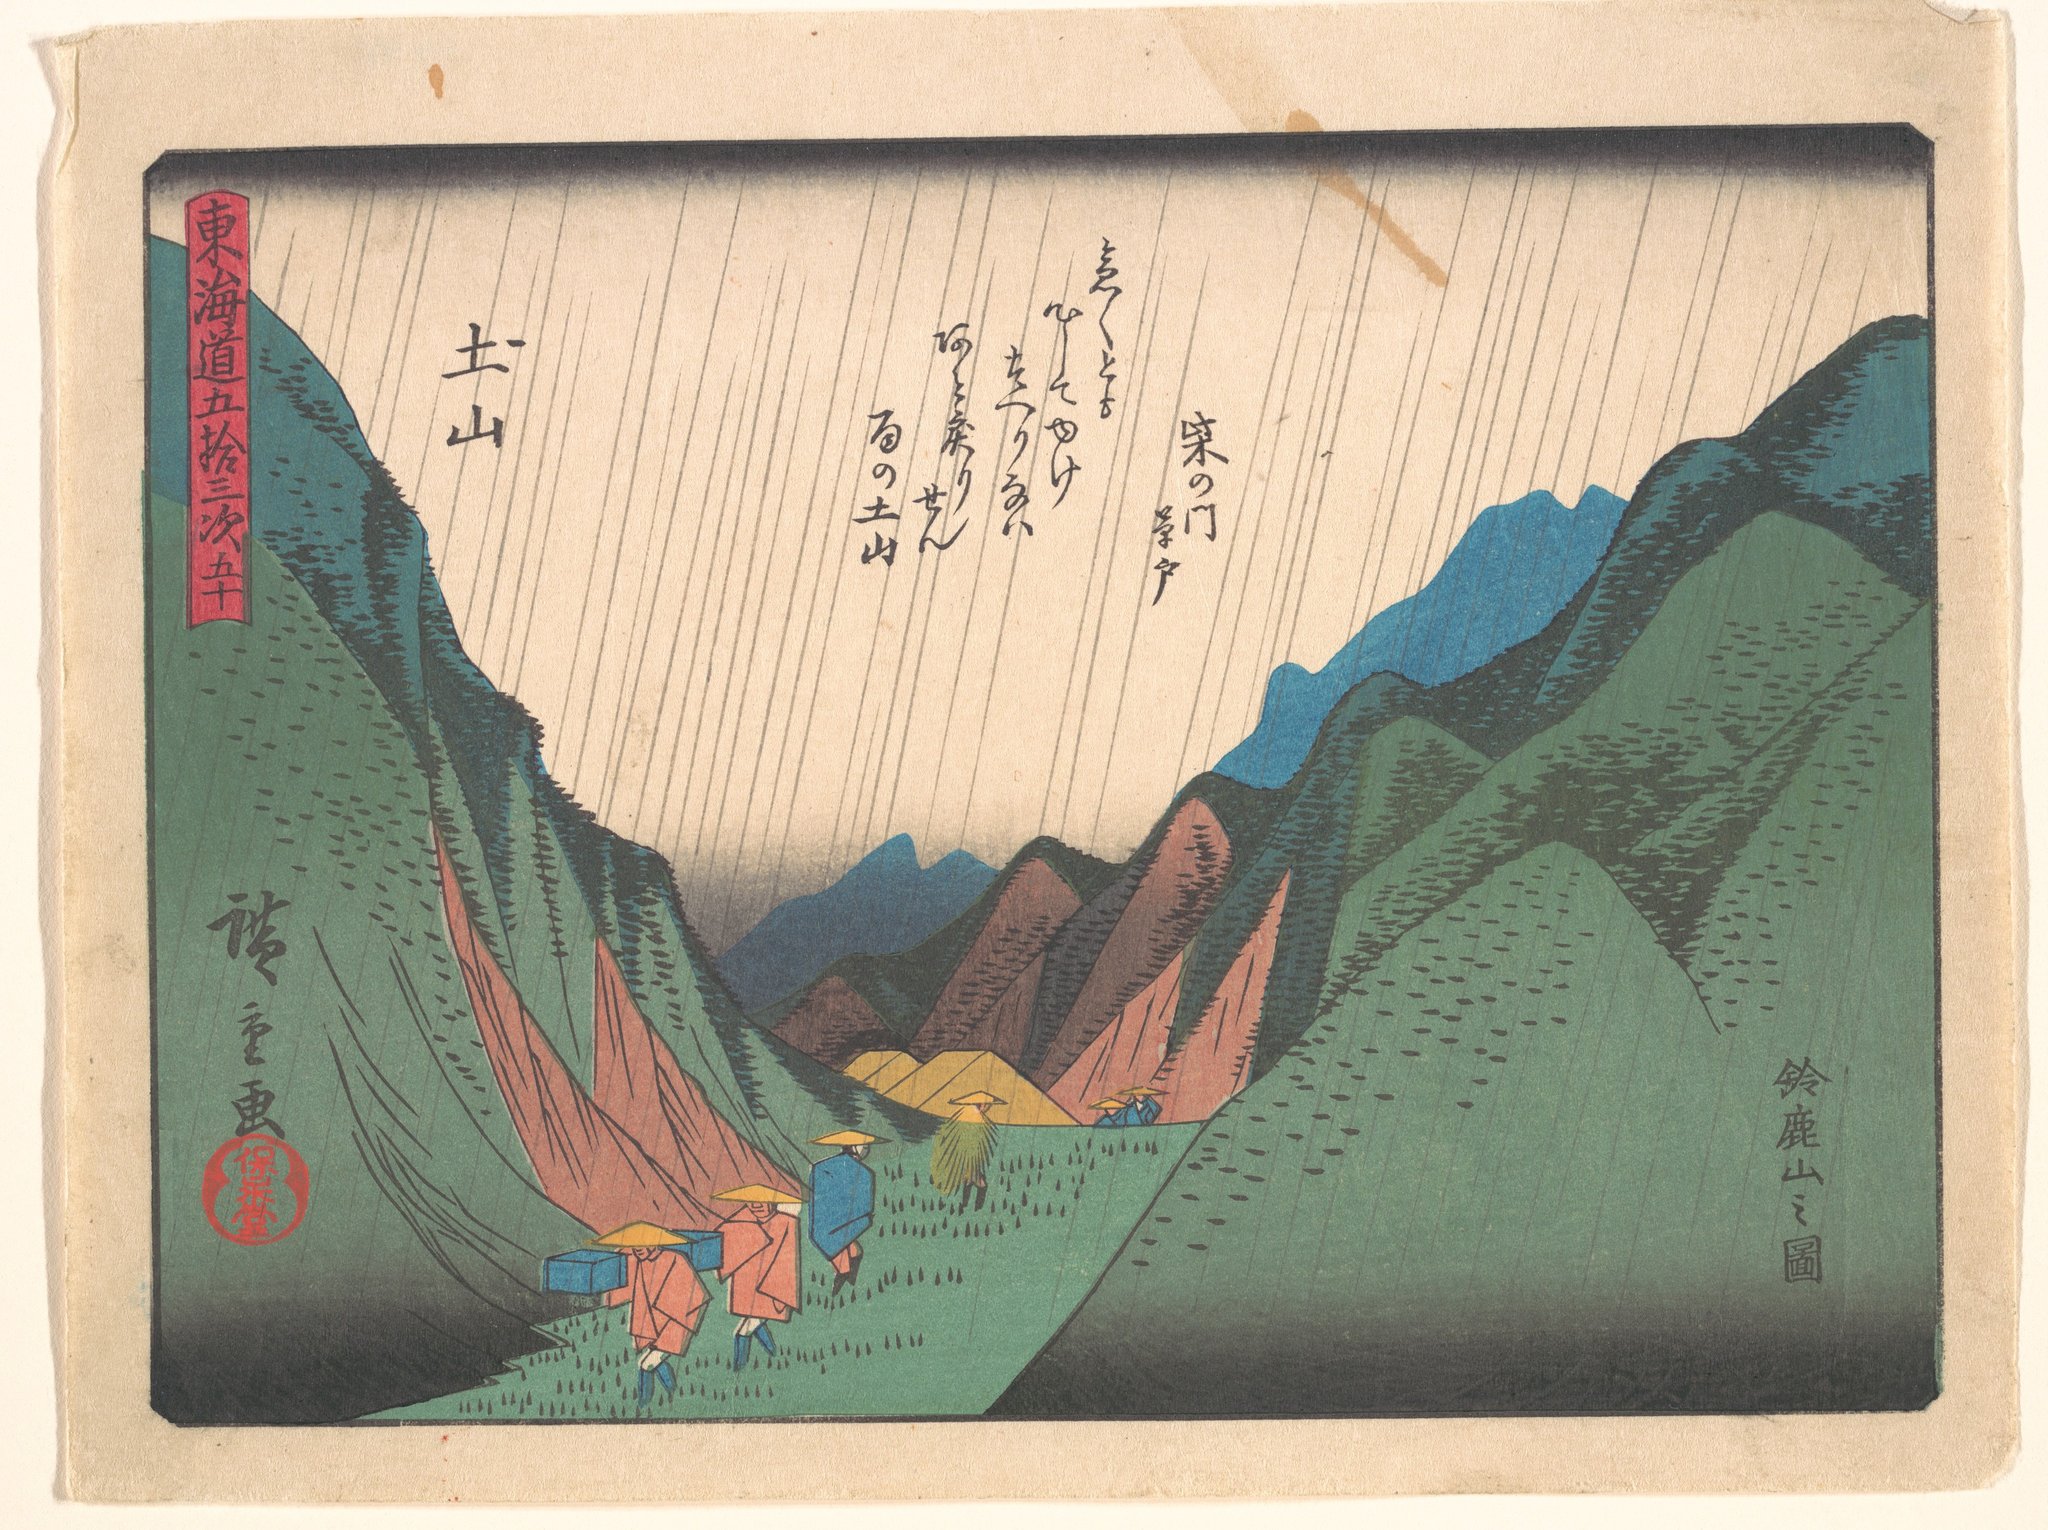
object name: print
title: Tsuchiyama, from the series The Fifty-three Stations of the Tōkaidō Road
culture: japanese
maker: utagawa hiroshige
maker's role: artist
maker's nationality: japanese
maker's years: 1797-1858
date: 1901-1933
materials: ink, paper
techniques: woodblock print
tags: human figures,streets,mountains